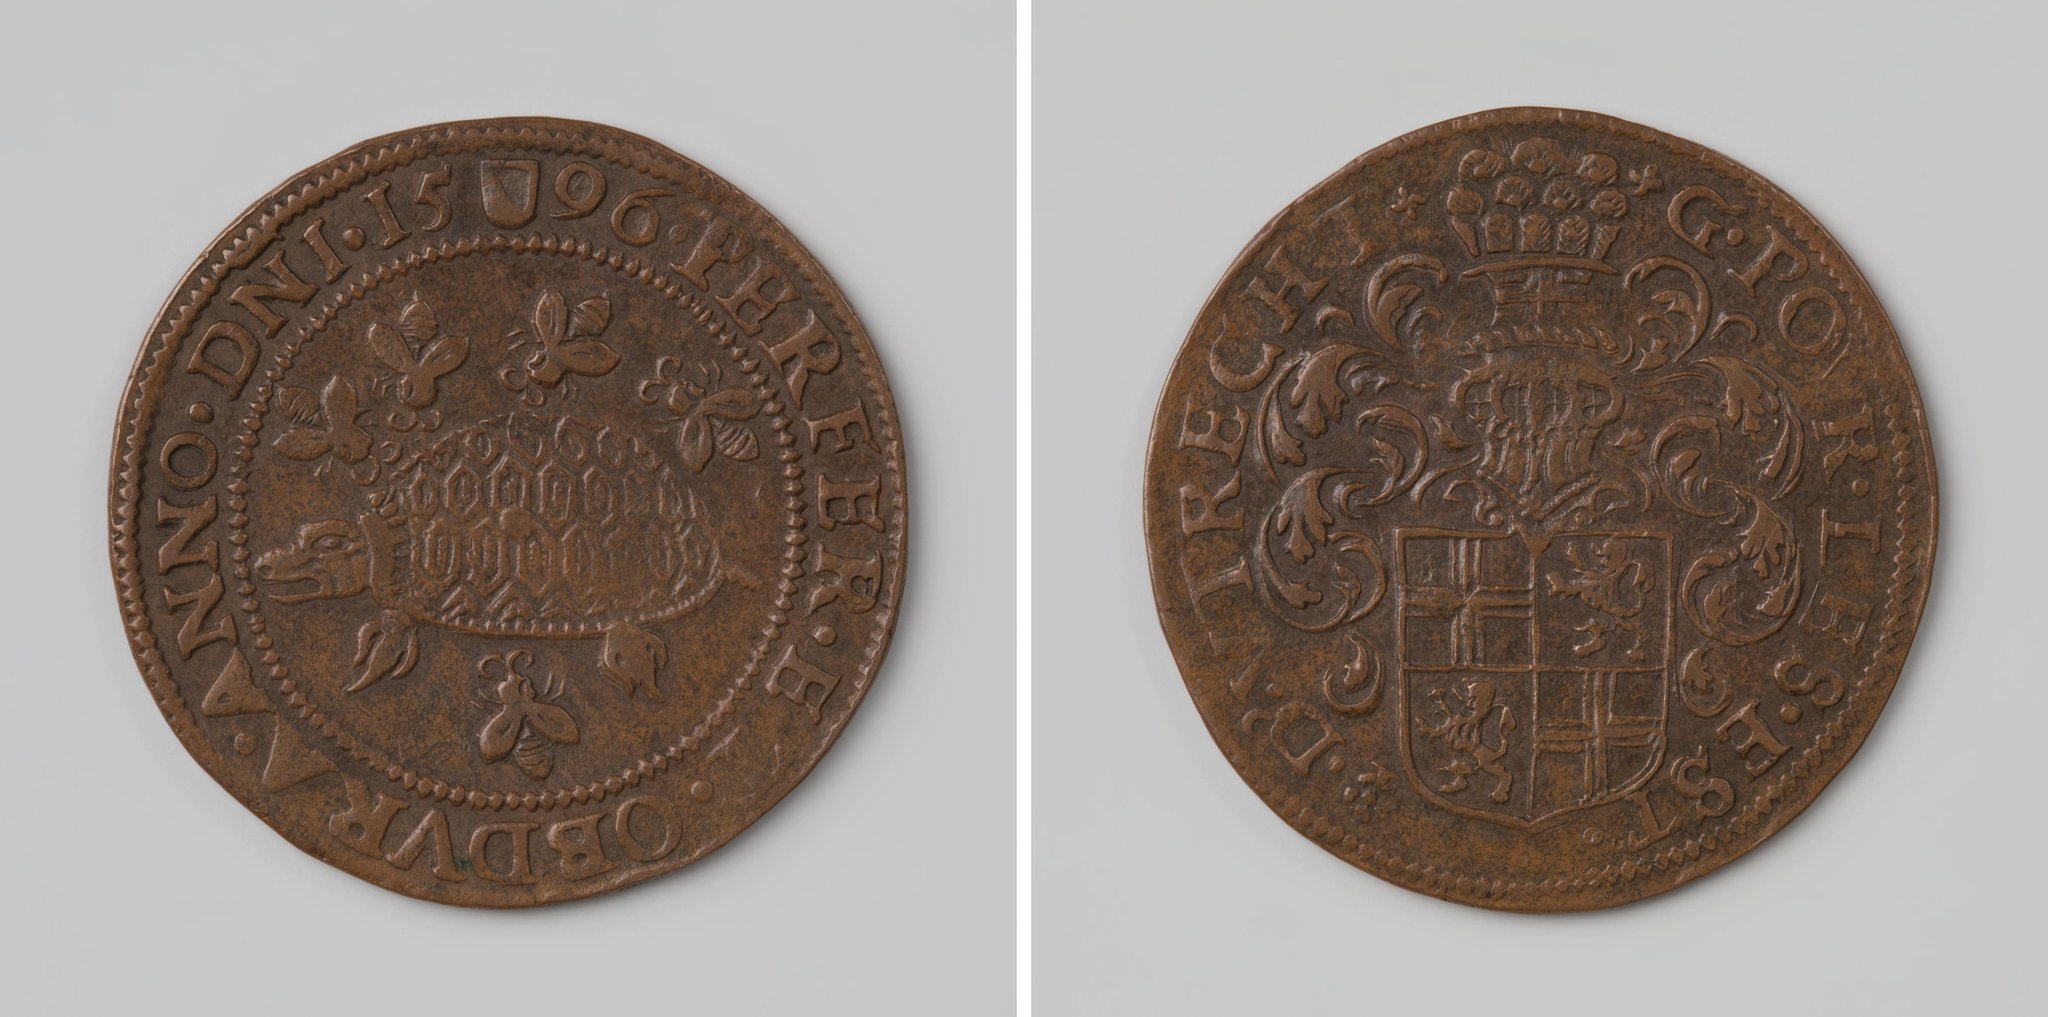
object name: jeton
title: Oproep om de druk der verhoogde belastingen geduldig te dragen, rekenpenning van de Staten van Utrecht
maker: Anonymous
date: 1596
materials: copper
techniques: striking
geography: utrecht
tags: utrecht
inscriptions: circumscription: ‘PERFER ET OBDVRA ANNO DNI 1596’, circumscription: ‘G POVR LES EST D VTRECHT’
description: Koperen penning. Voorzijde: schildpad, die door vijf bijen wordt aangevallen binnen omschrift. Keerzijde: gehelmd wapenschild onder korf met veren binnen omschrift.